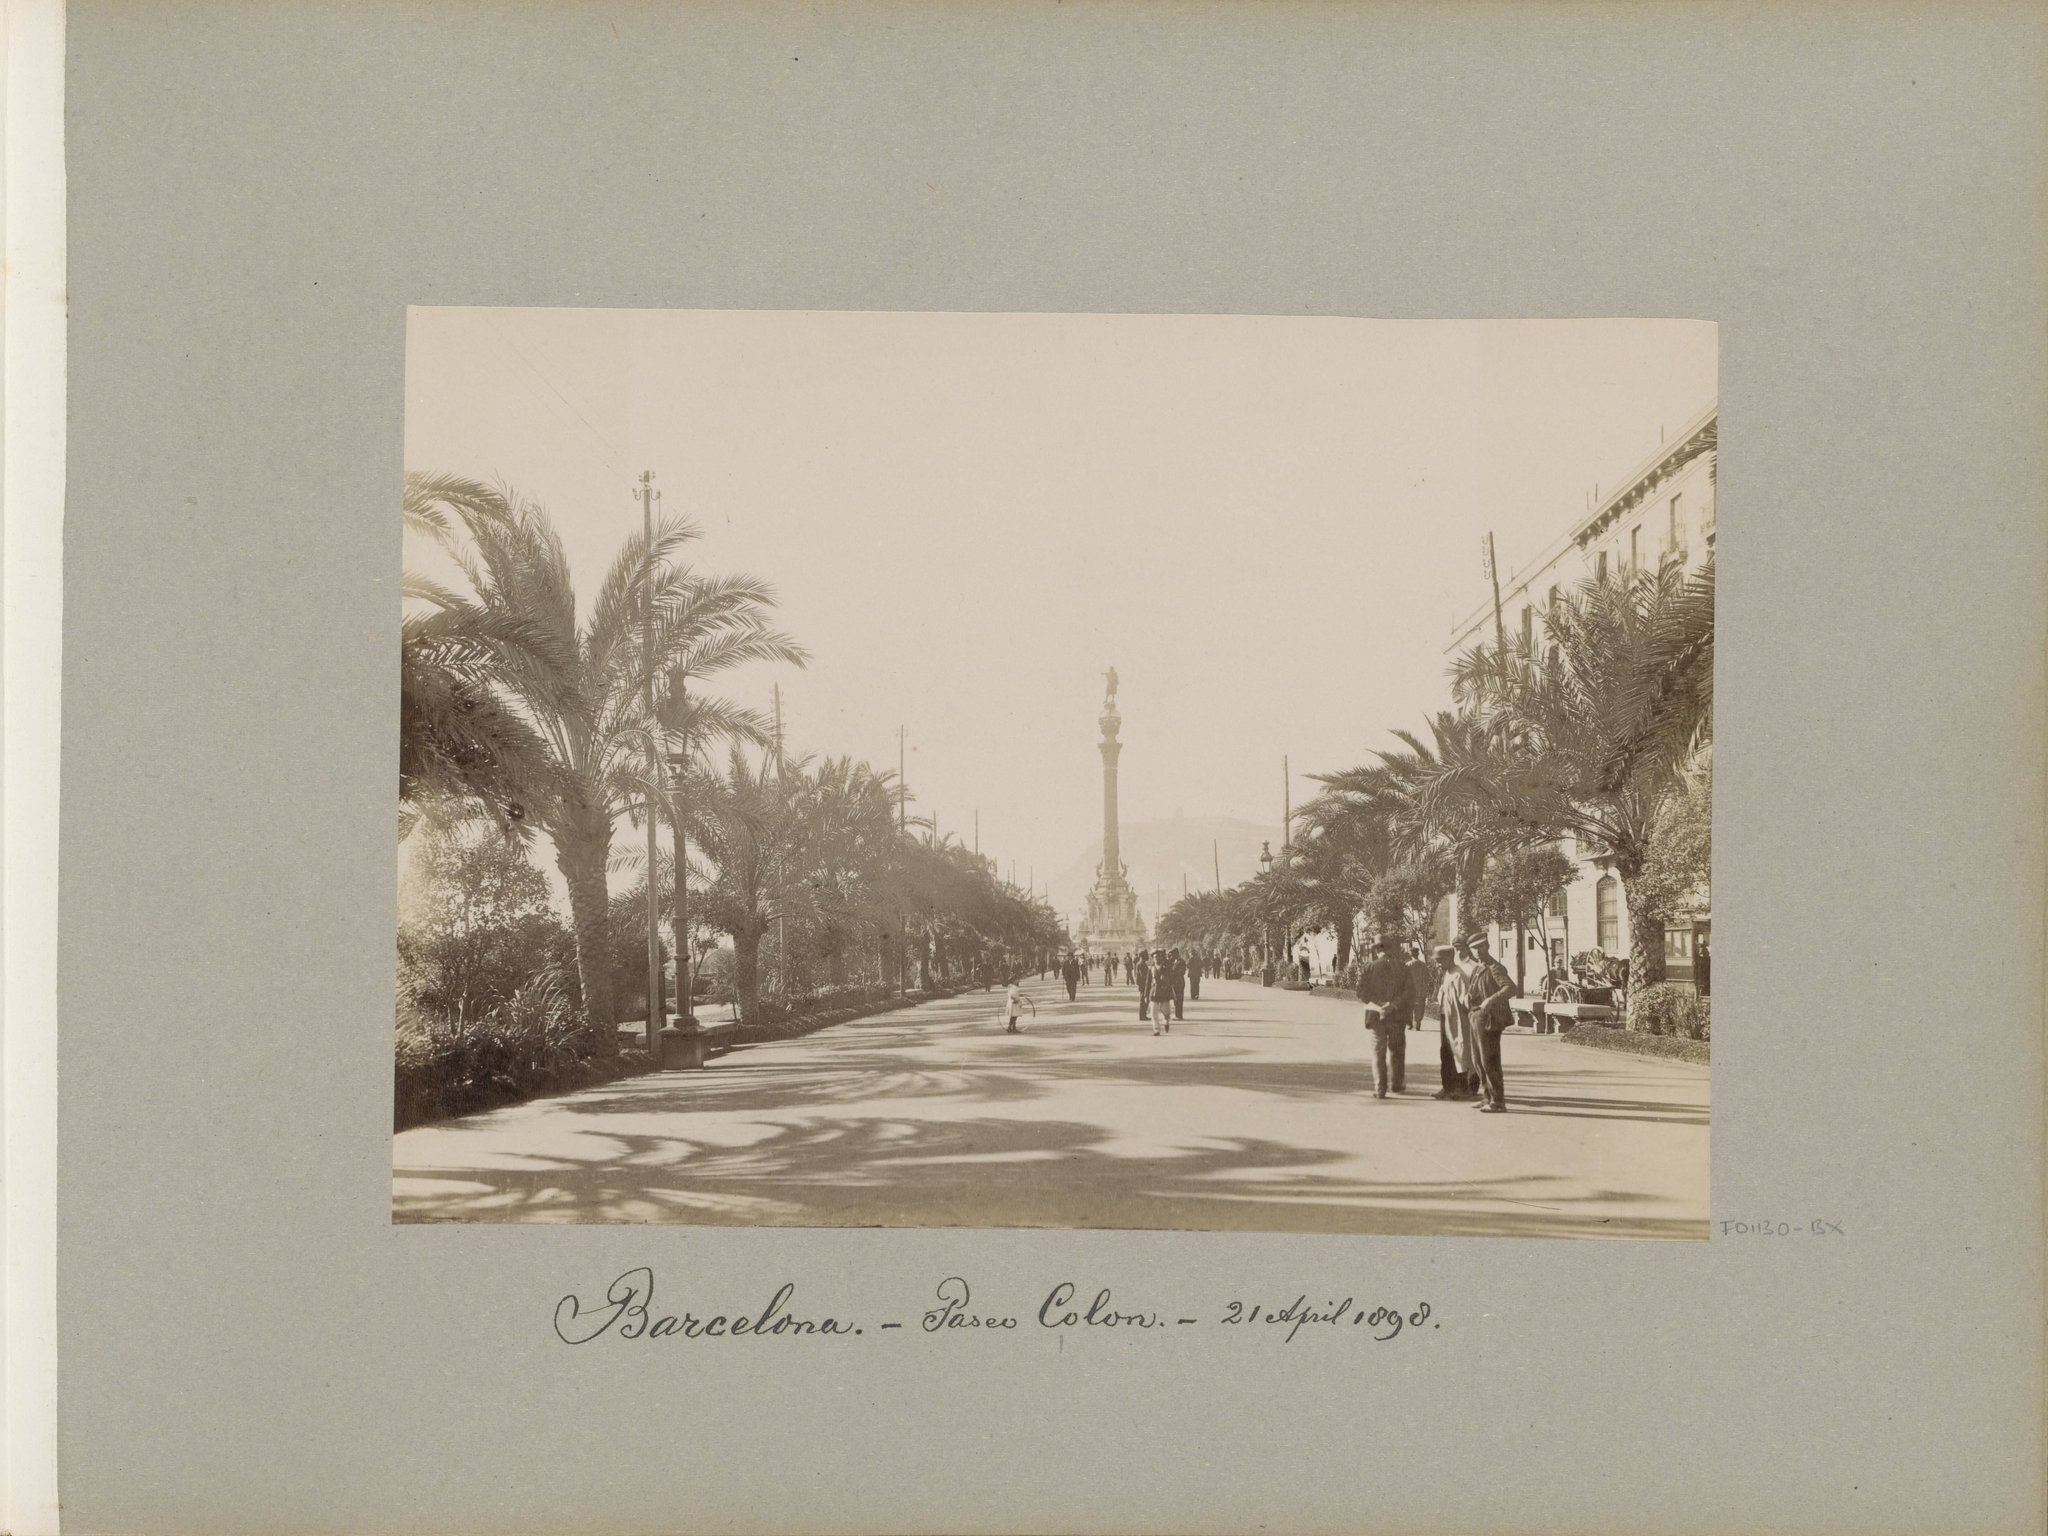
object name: album leaf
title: Paseo de Colón in Barcelona met aan het einde het monument voor Columbus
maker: Anonymous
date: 1880-1898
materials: paper, photographic support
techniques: albumen print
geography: barcelona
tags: monument, statue, street (+ city(-scape) with figures, staffage)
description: Onderdeel van Reisalbum met foto's van bezienswaardigheden in Frankrijk, Spanje, Italië, Duitsland, Zwitserland en Oostenrijk.